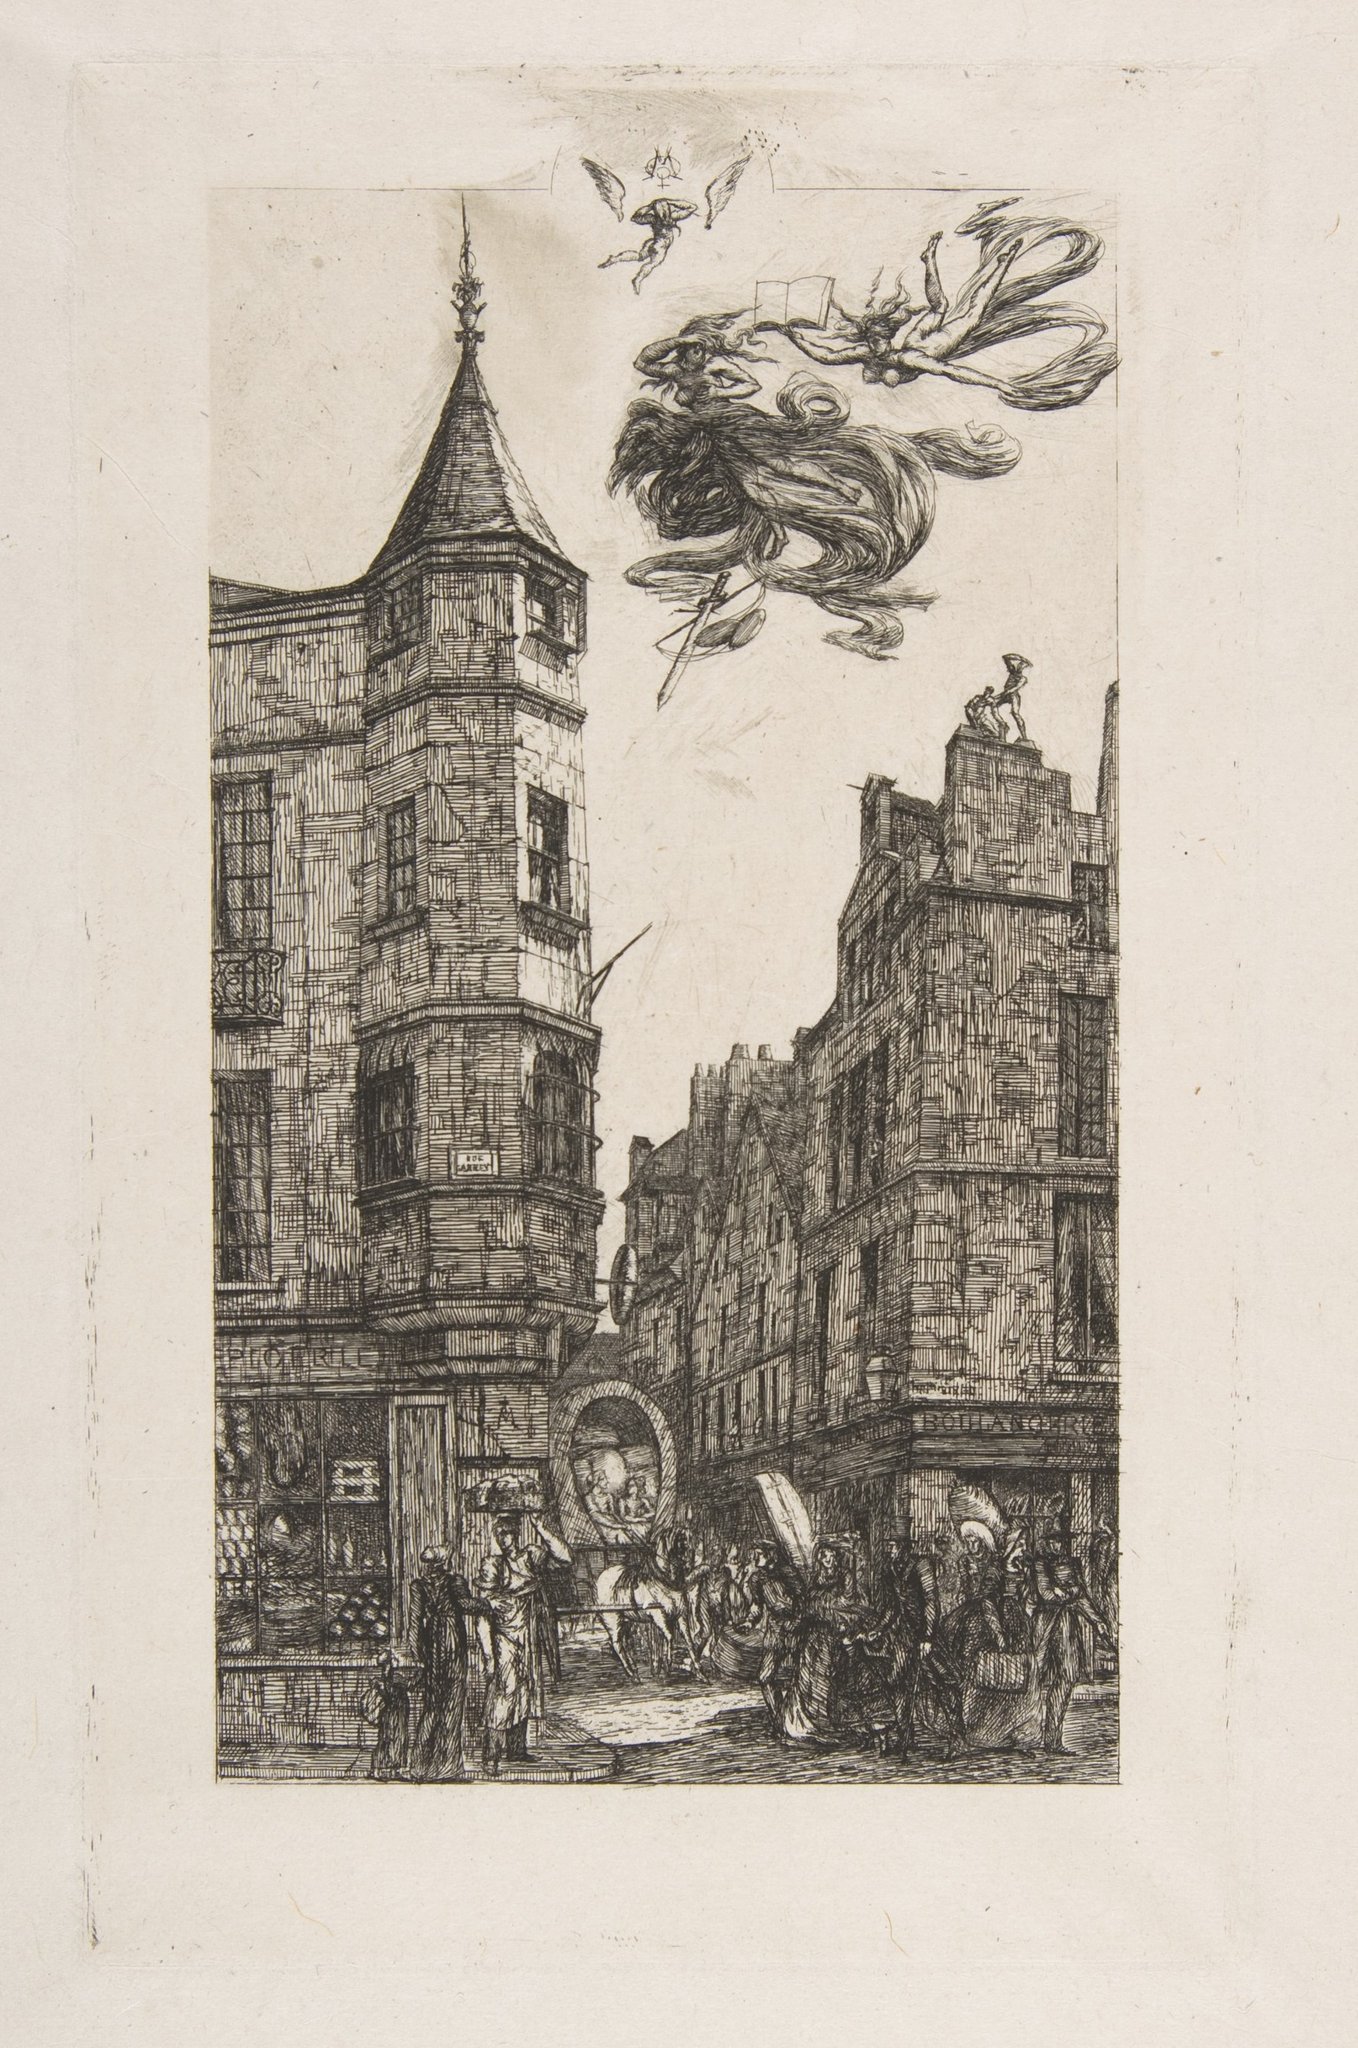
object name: print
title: Tourelle Rue de l'Ecole de Médecine, 22 (House with a Turret, No 22, rue de l'Ecole de Médecine, Paris) (called the Turret of Marat)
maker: charles meryon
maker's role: artist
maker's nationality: french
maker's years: 1821-1868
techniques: drypoint, etching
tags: houses,cities,paris